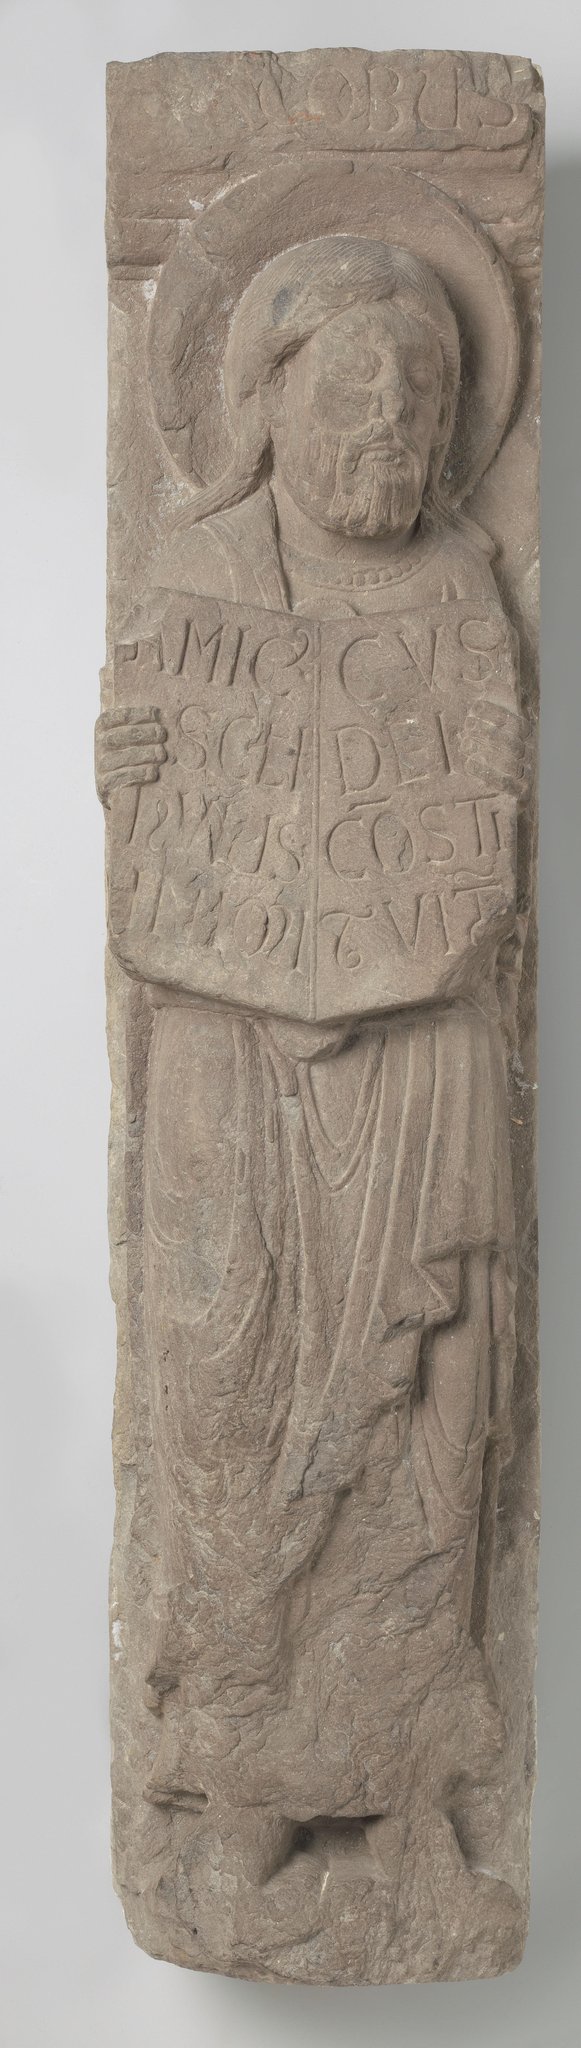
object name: stile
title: St James, from an ambo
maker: Anonymous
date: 1150-1170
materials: stone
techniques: carved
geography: maastricht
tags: sint odiliënberg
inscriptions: inscription, on the profiled border above: ‘[S.IA]COBUS’, inscription, on the book: ‘AMIC[US] S[AE]C[U]LI HVIUS INIMICUS DEI CO[N]STITVIT[UR]’